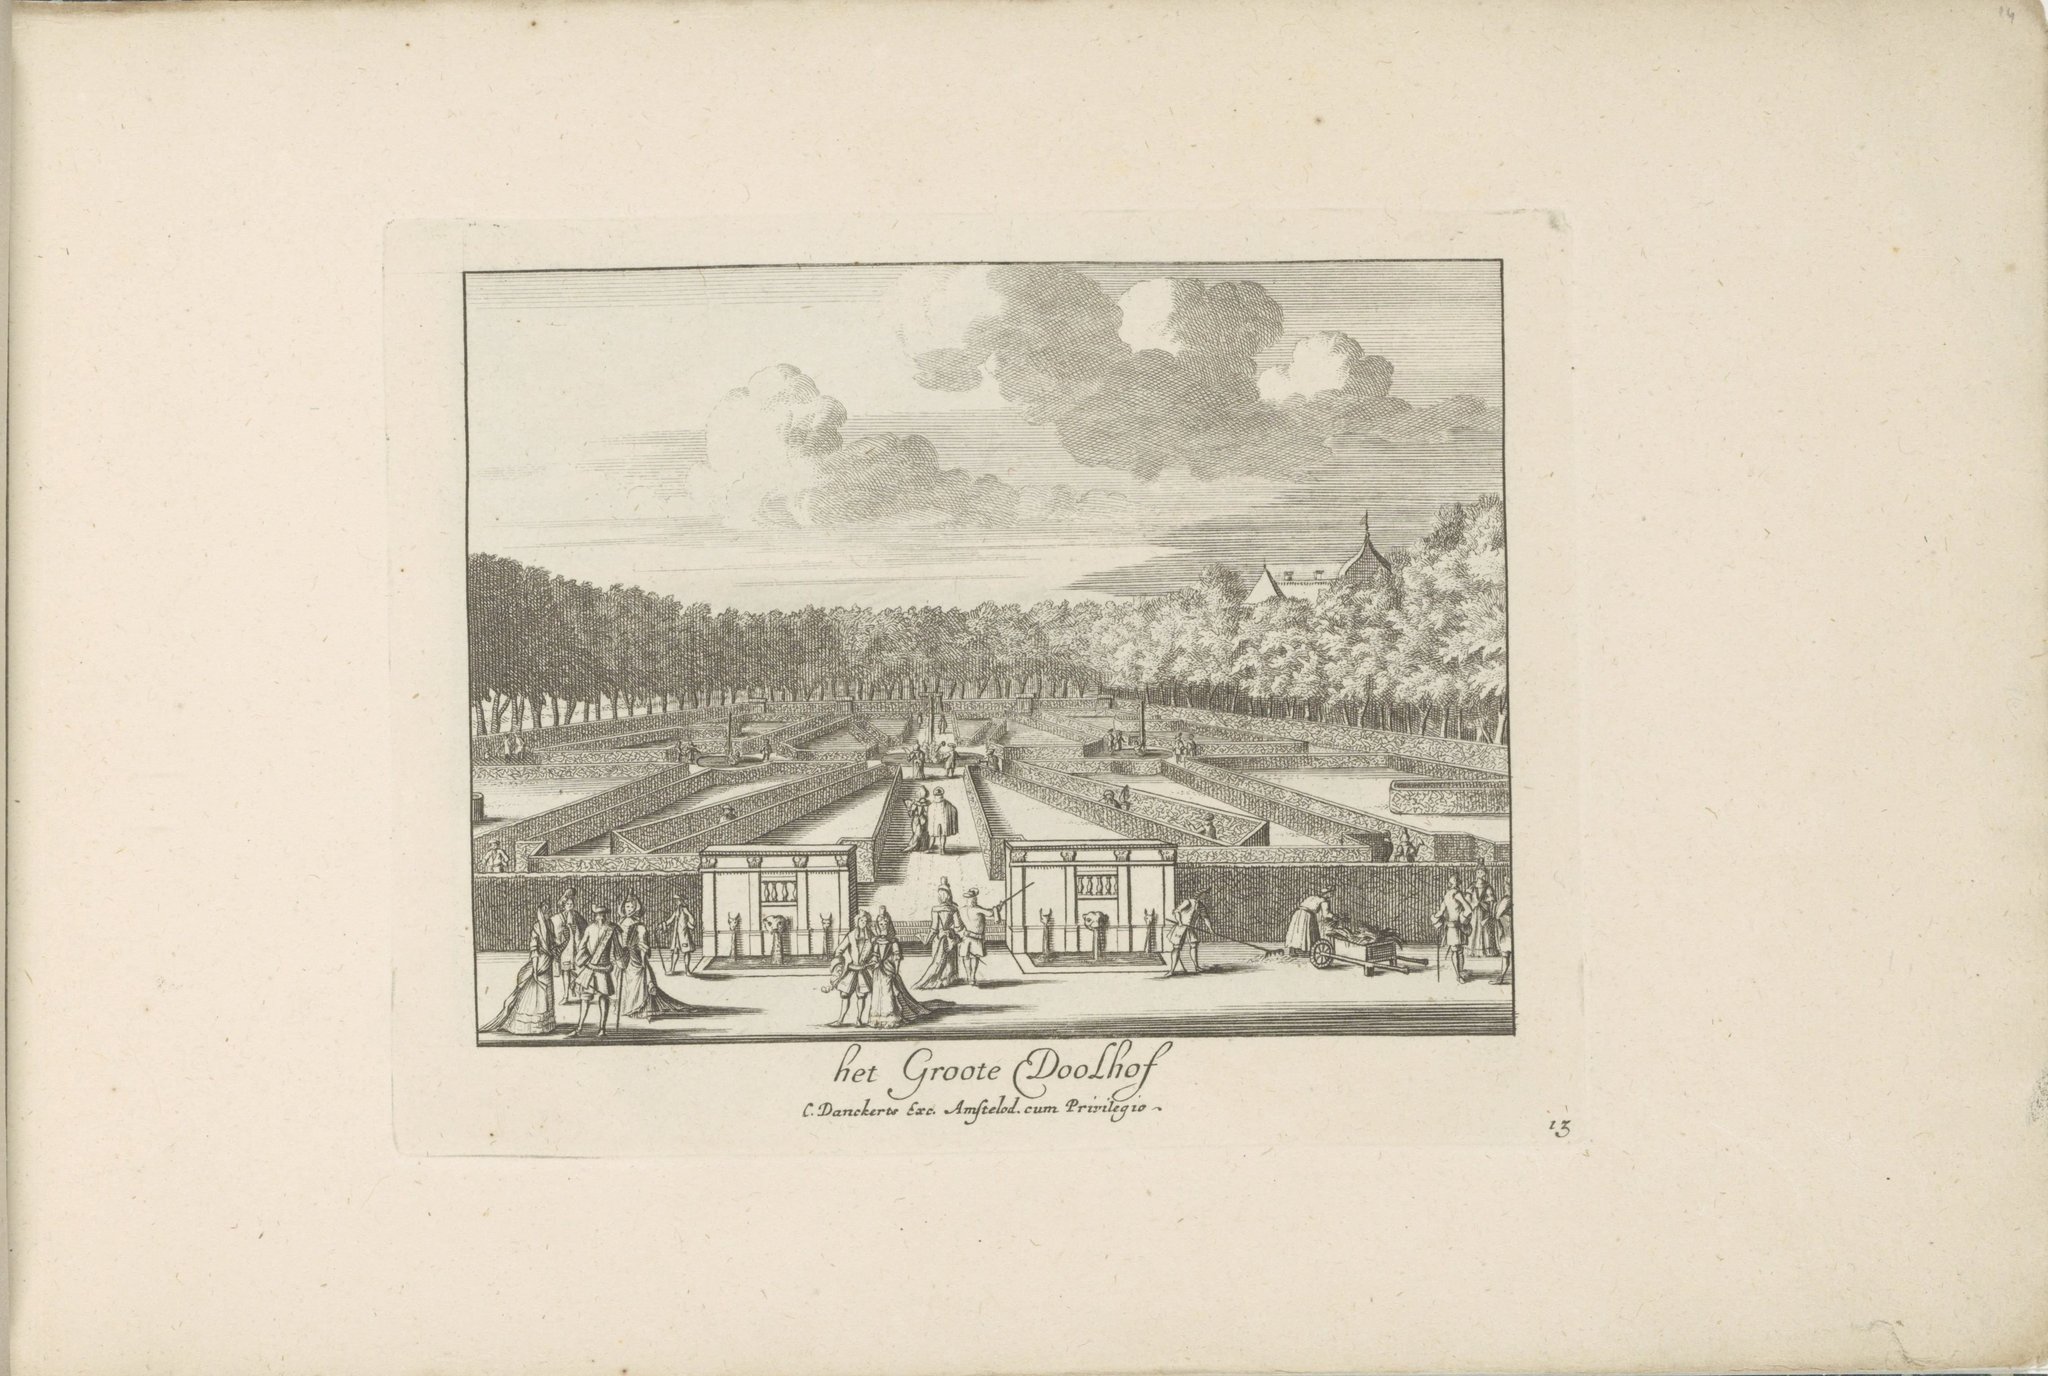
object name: print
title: Het Groote Doolhof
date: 1696-1718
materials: paper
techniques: etching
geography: amsterdam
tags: palace, labyrinth, maze ~ garden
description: Gezicht op het doolhof in de tuin van Paleis Het Loo. Prent maakt deel uit van een album.